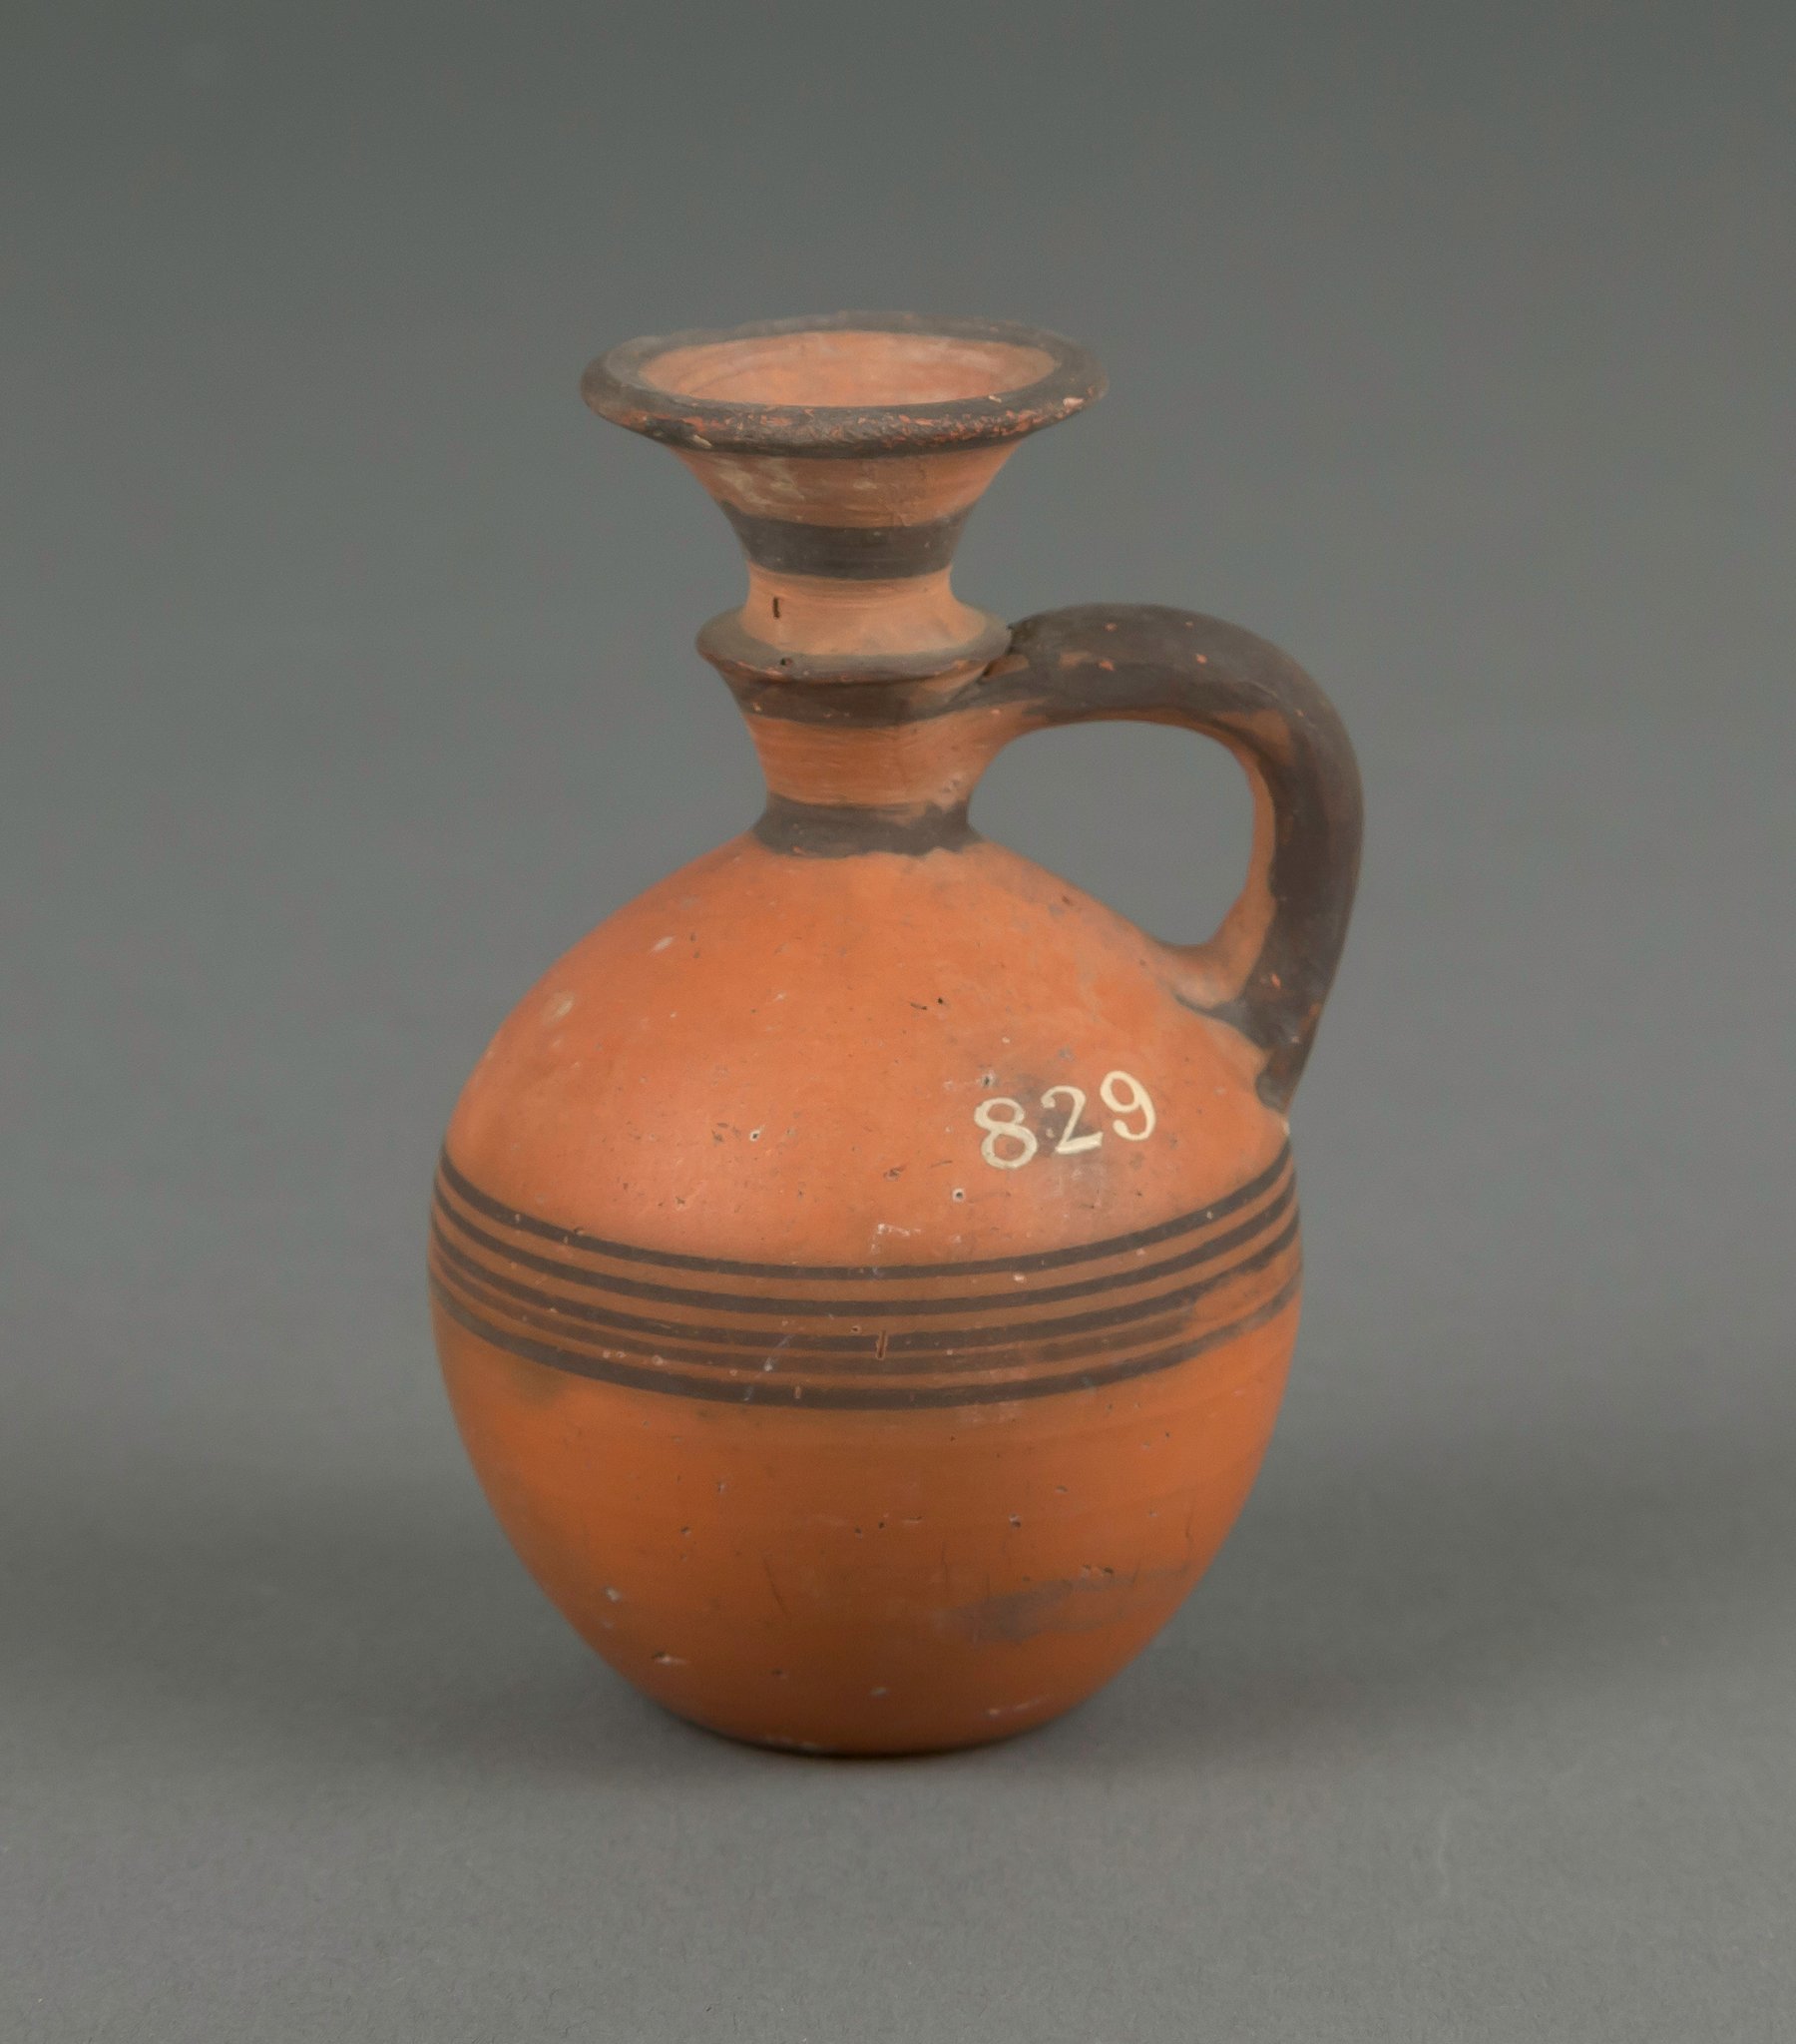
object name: jug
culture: cypriot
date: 1050-900 BCE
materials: terracotta